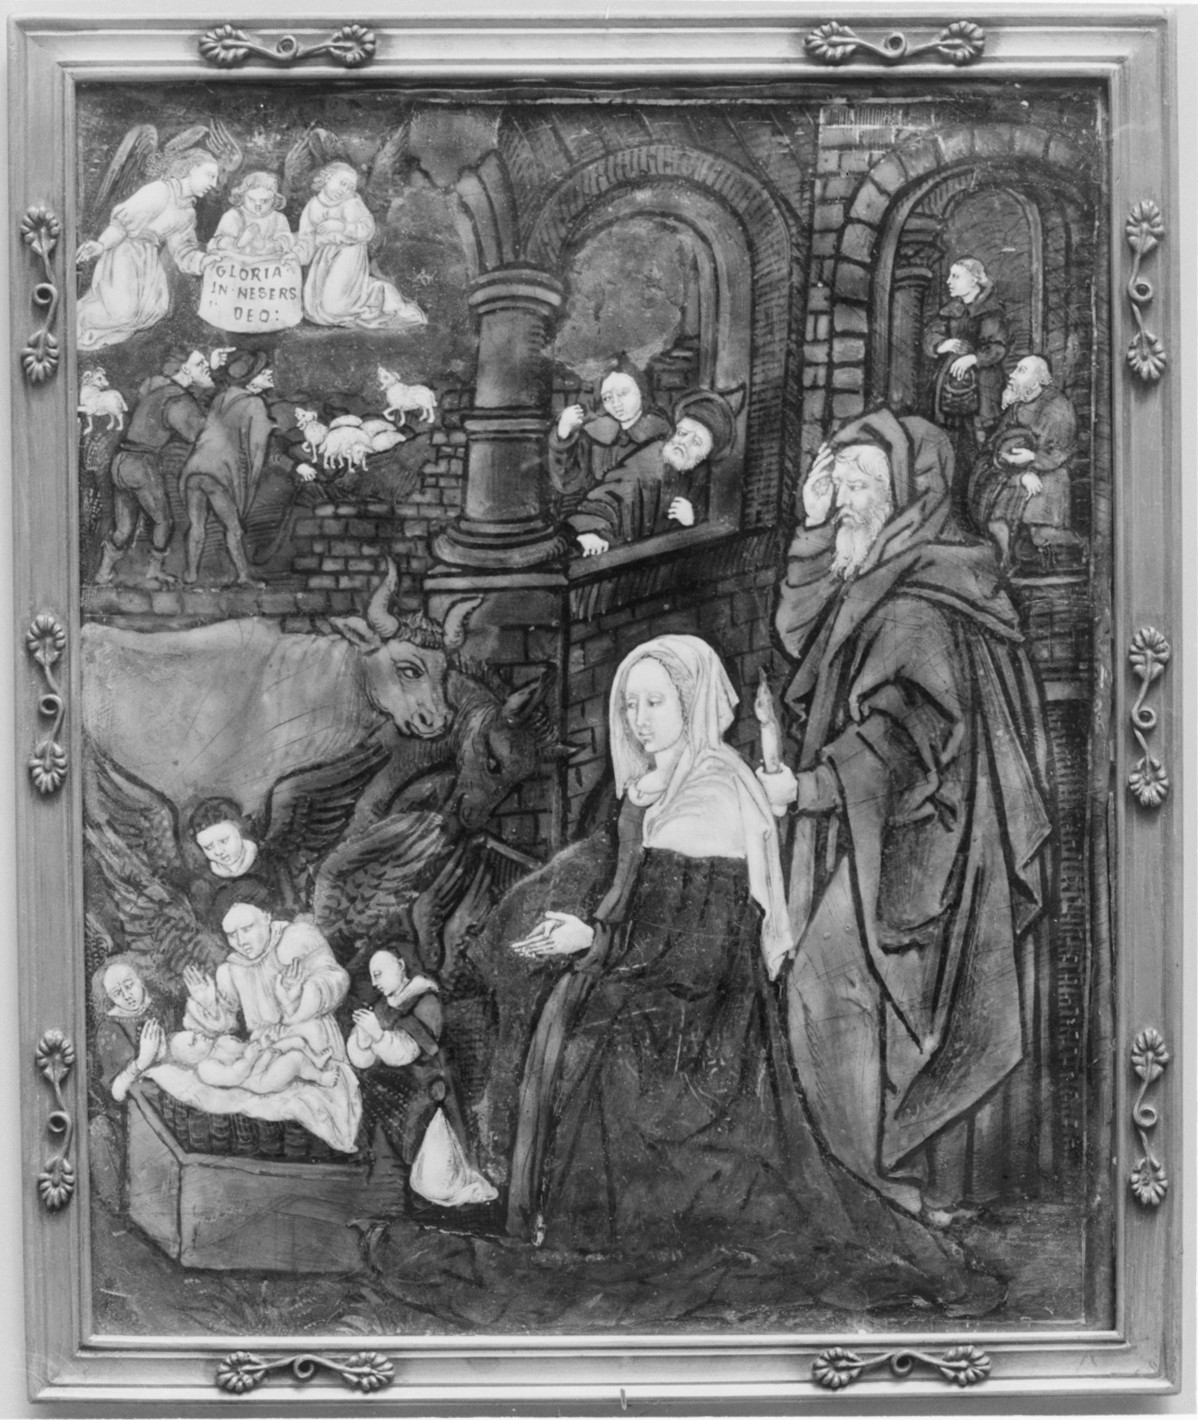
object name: plaque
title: The Nativity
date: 1526-1550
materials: copper, enamel, gilt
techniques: painting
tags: animals,angels,virgin mary,jesus,nativity